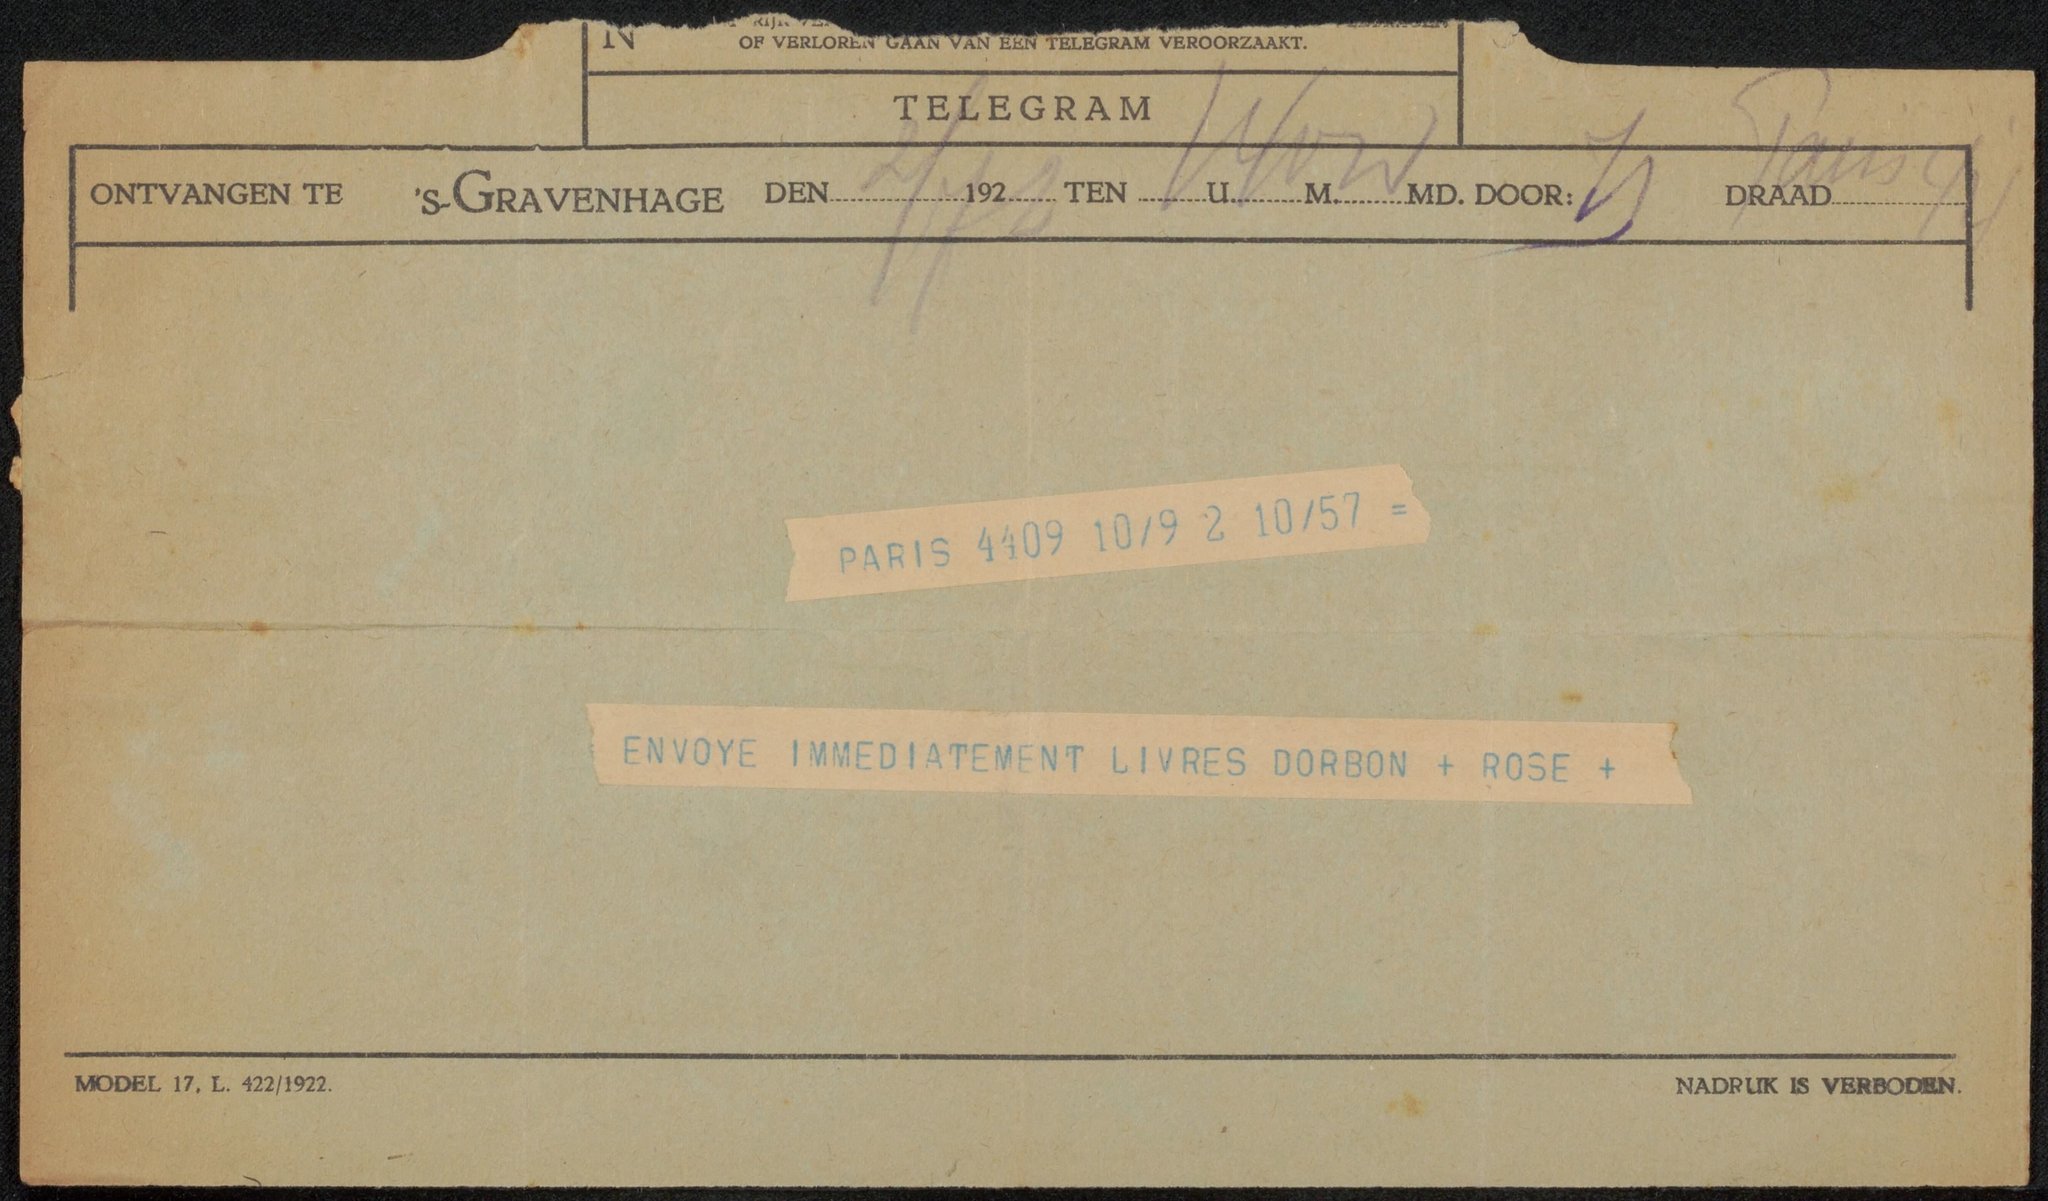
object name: telegram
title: Telegram aan Philip Zilcken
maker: rose imel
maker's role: draughtsman, painter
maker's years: 1901-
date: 1922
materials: paper, pencil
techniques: printing, typewriting, writing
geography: paris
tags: paris, publisher, painter, draughtsman, philip zilcken, printed matter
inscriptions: collector's mark: ‘RPK’